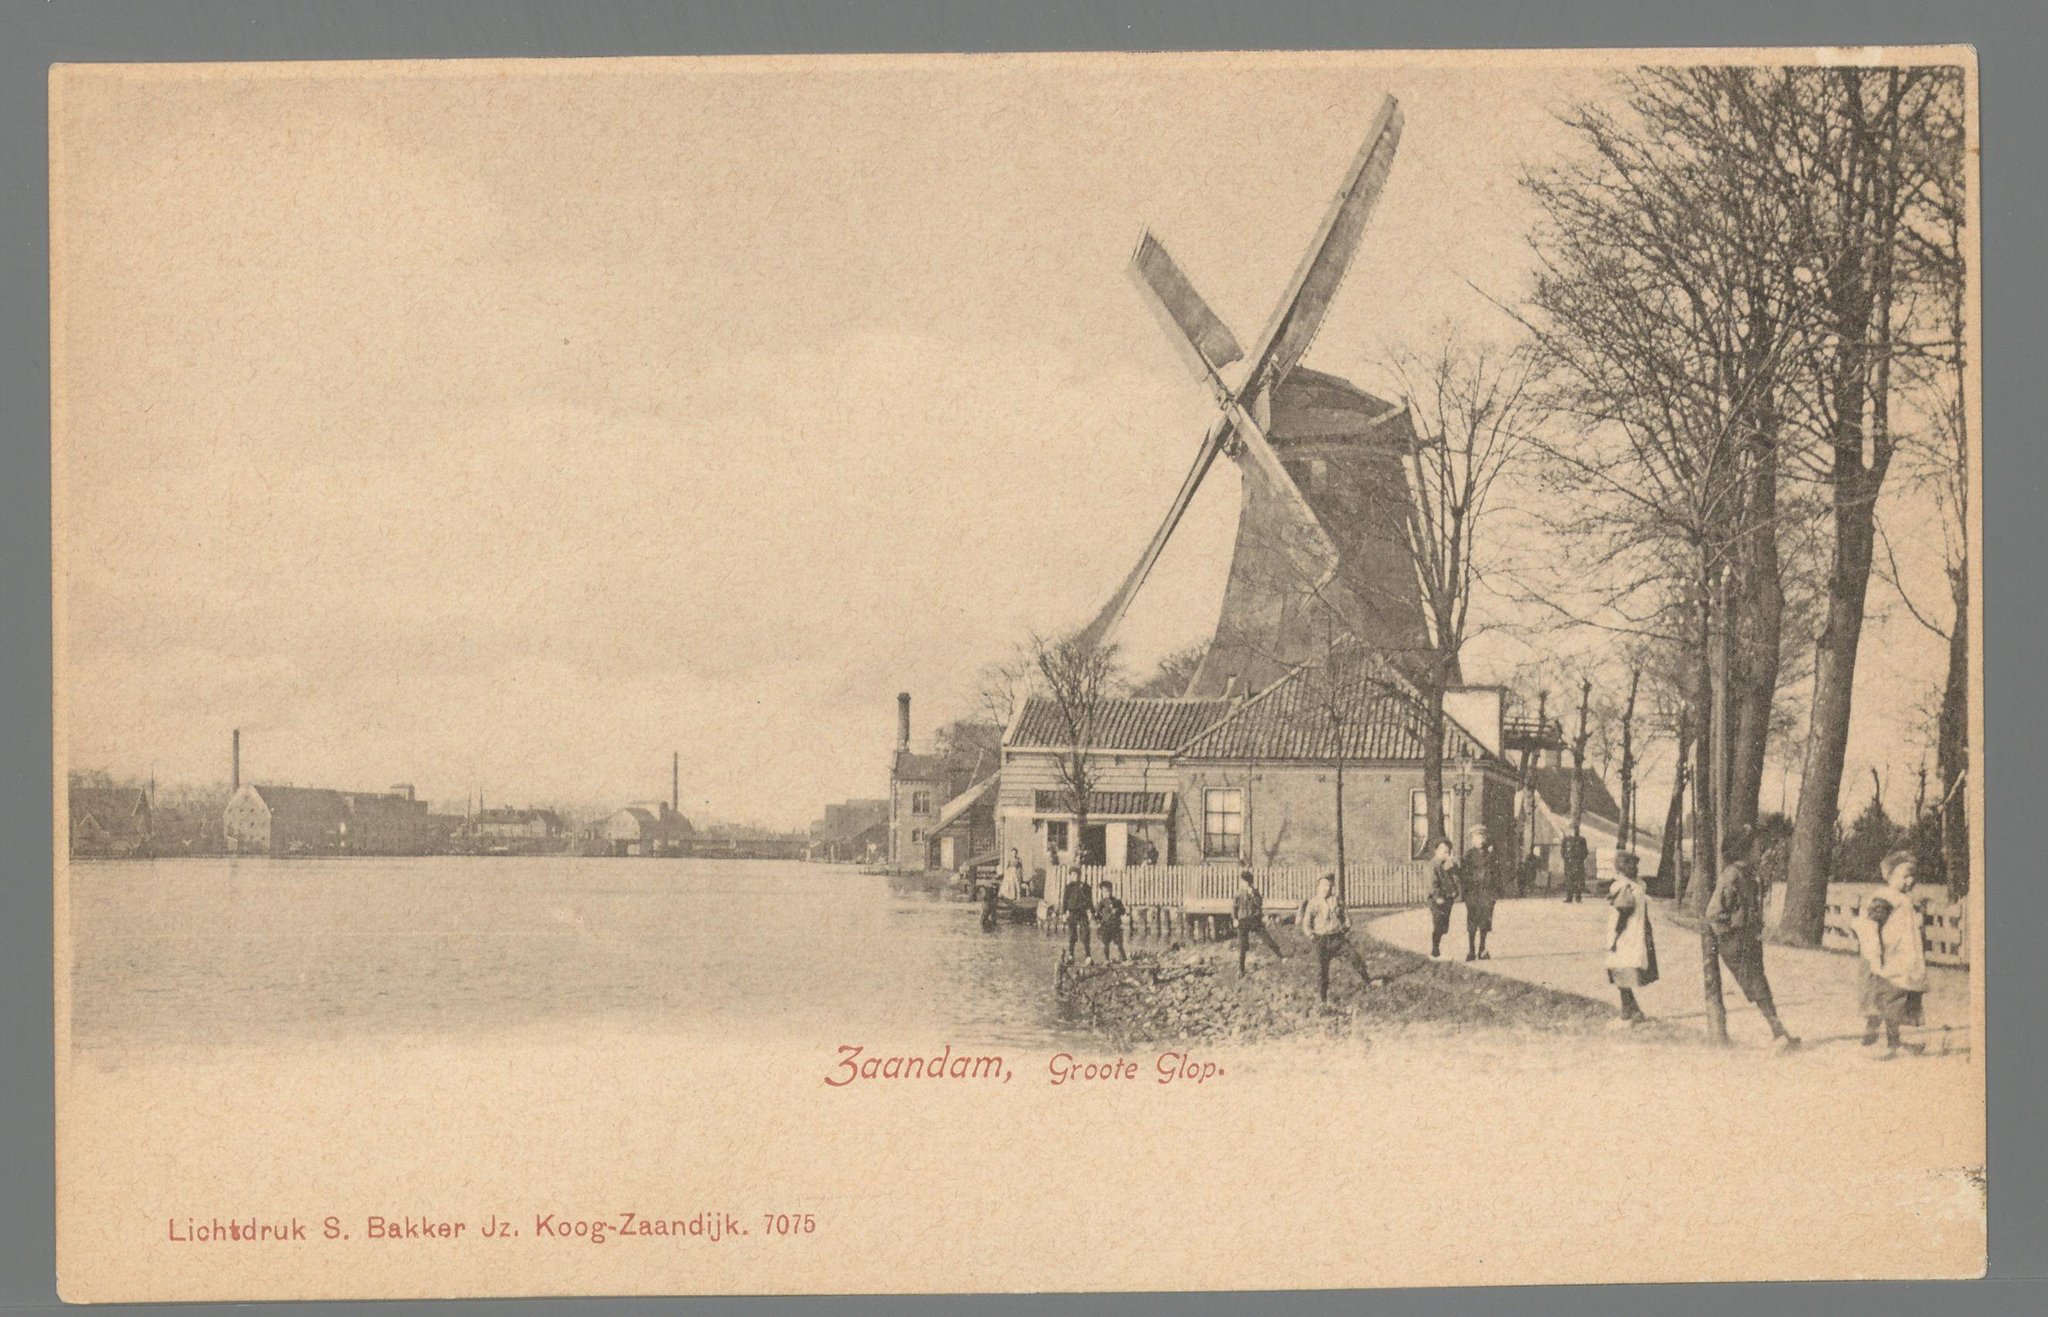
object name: ansichtkaart, prentbriefkaart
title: Zaandam, Groote Glop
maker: simon bakker jz.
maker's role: printer, publisher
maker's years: 1873-1930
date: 1899-1905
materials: cardboard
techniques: photograph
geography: koog aan de zaan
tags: windmill in landscape